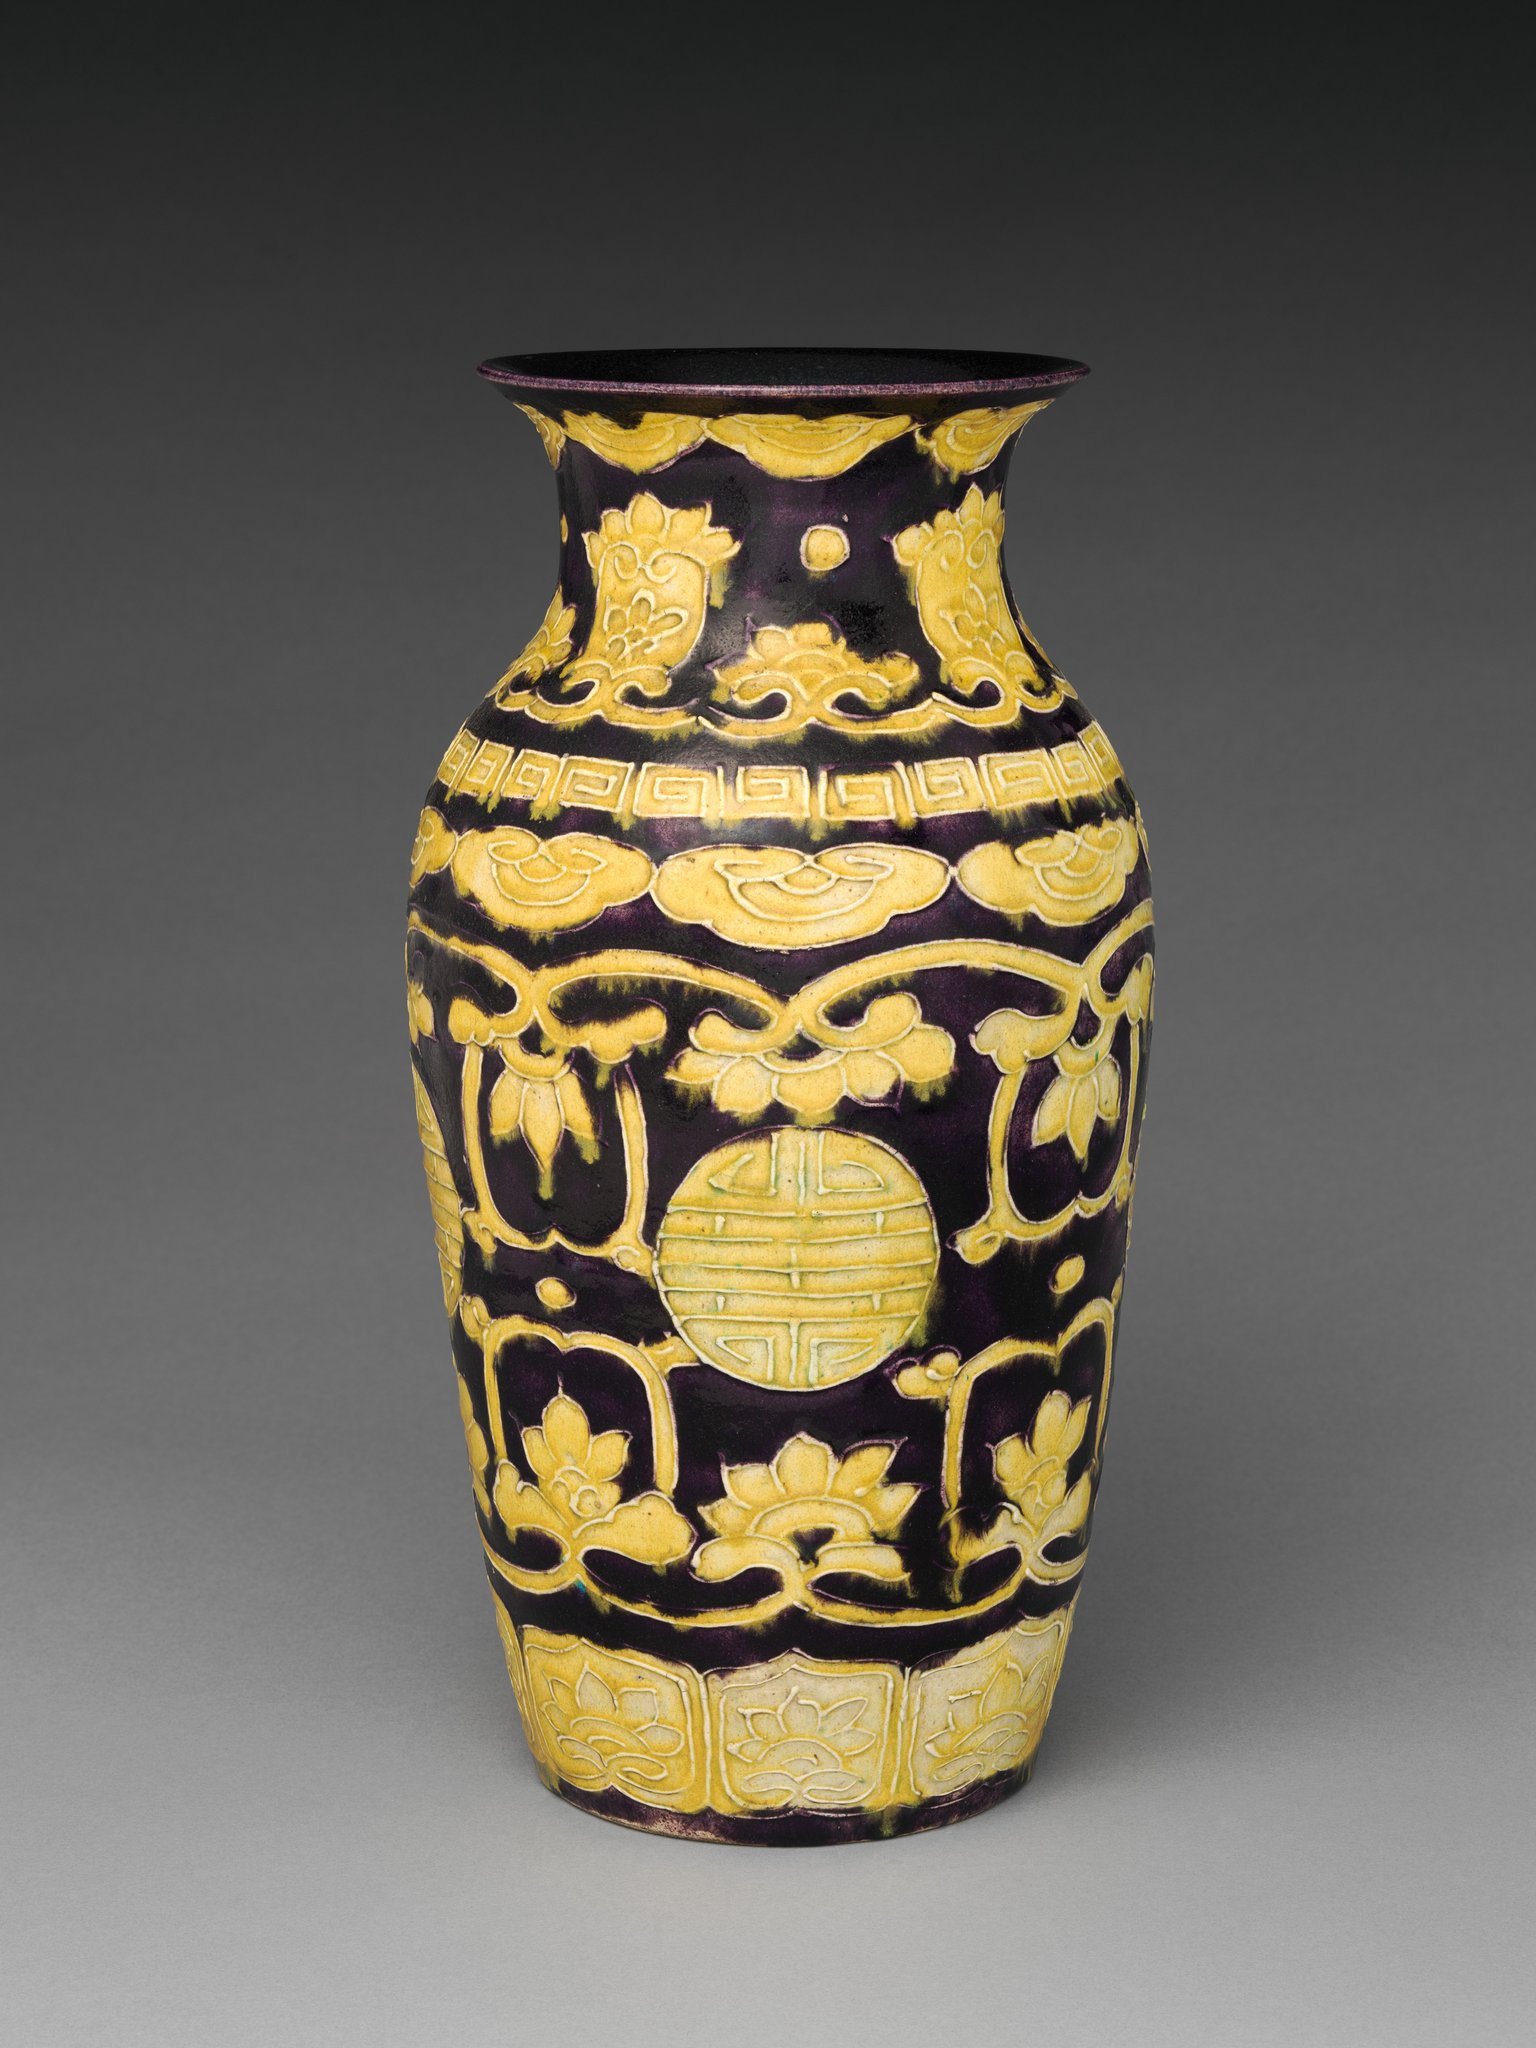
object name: jar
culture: japanese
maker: bukkadō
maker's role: artist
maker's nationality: japanese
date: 1801-1900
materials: paste, porcelain